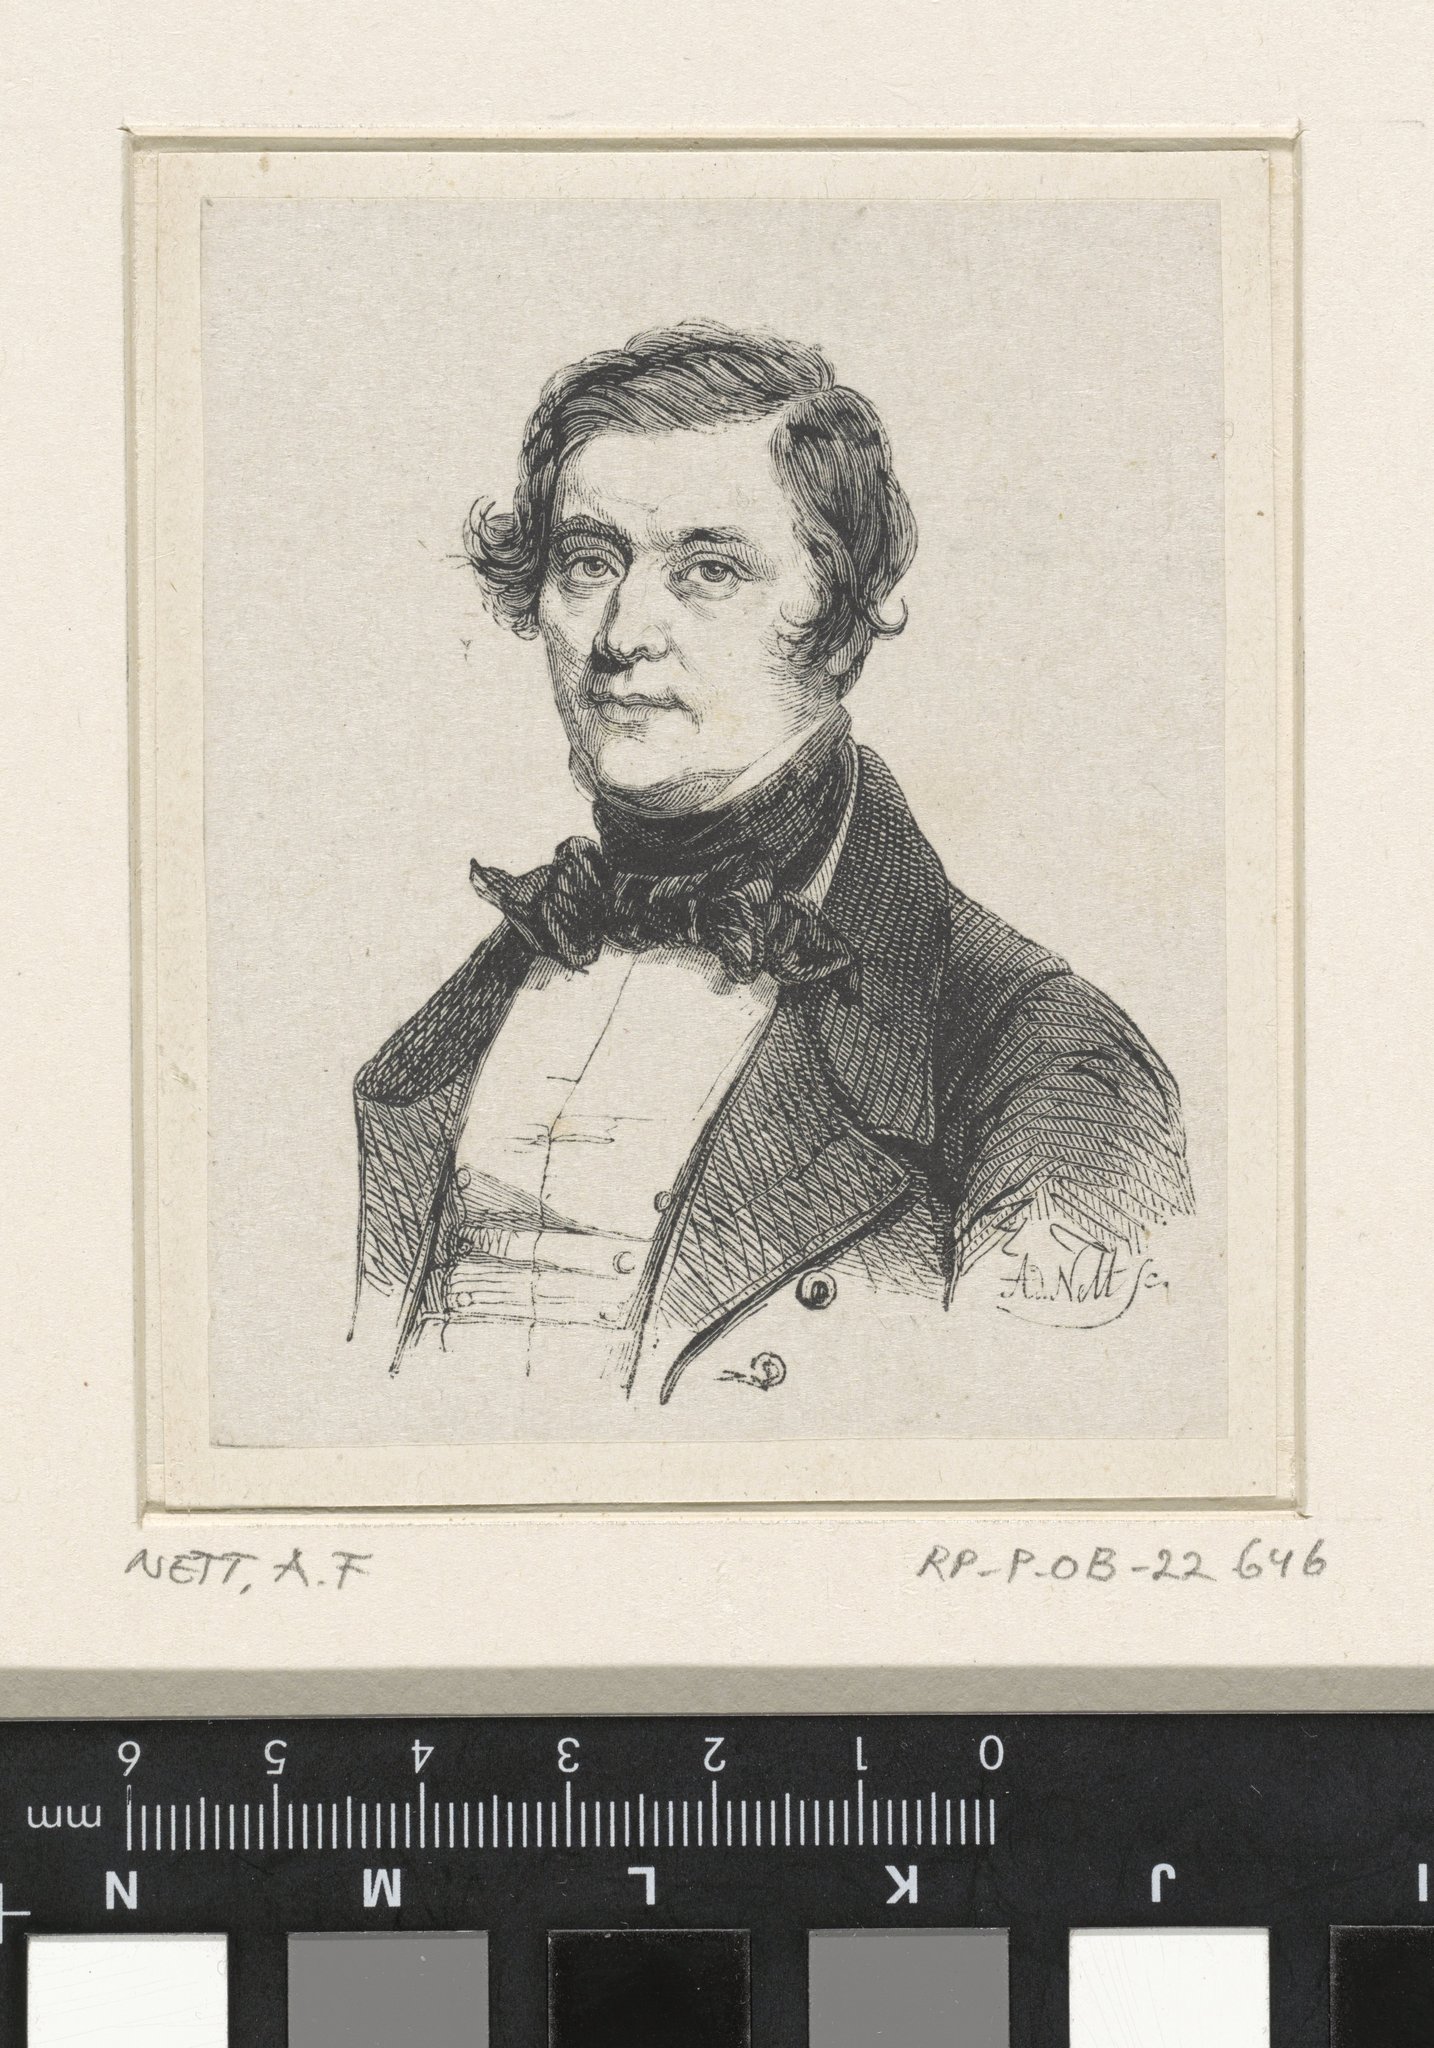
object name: print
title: Portret van Antonie Waldorp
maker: adolphe frédéric nett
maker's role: print maker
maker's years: 1822-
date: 1832-1900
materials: paper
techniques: engraving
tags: the hague, amsterdam, painter, draughtsman, antonie waldorp, historical persons, portrait, self-portrait of painter, portrait, self-portrait of artist, portrait, self-portrait of graphic artist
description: Portret van schilder en graveur Antonie Waldorp.